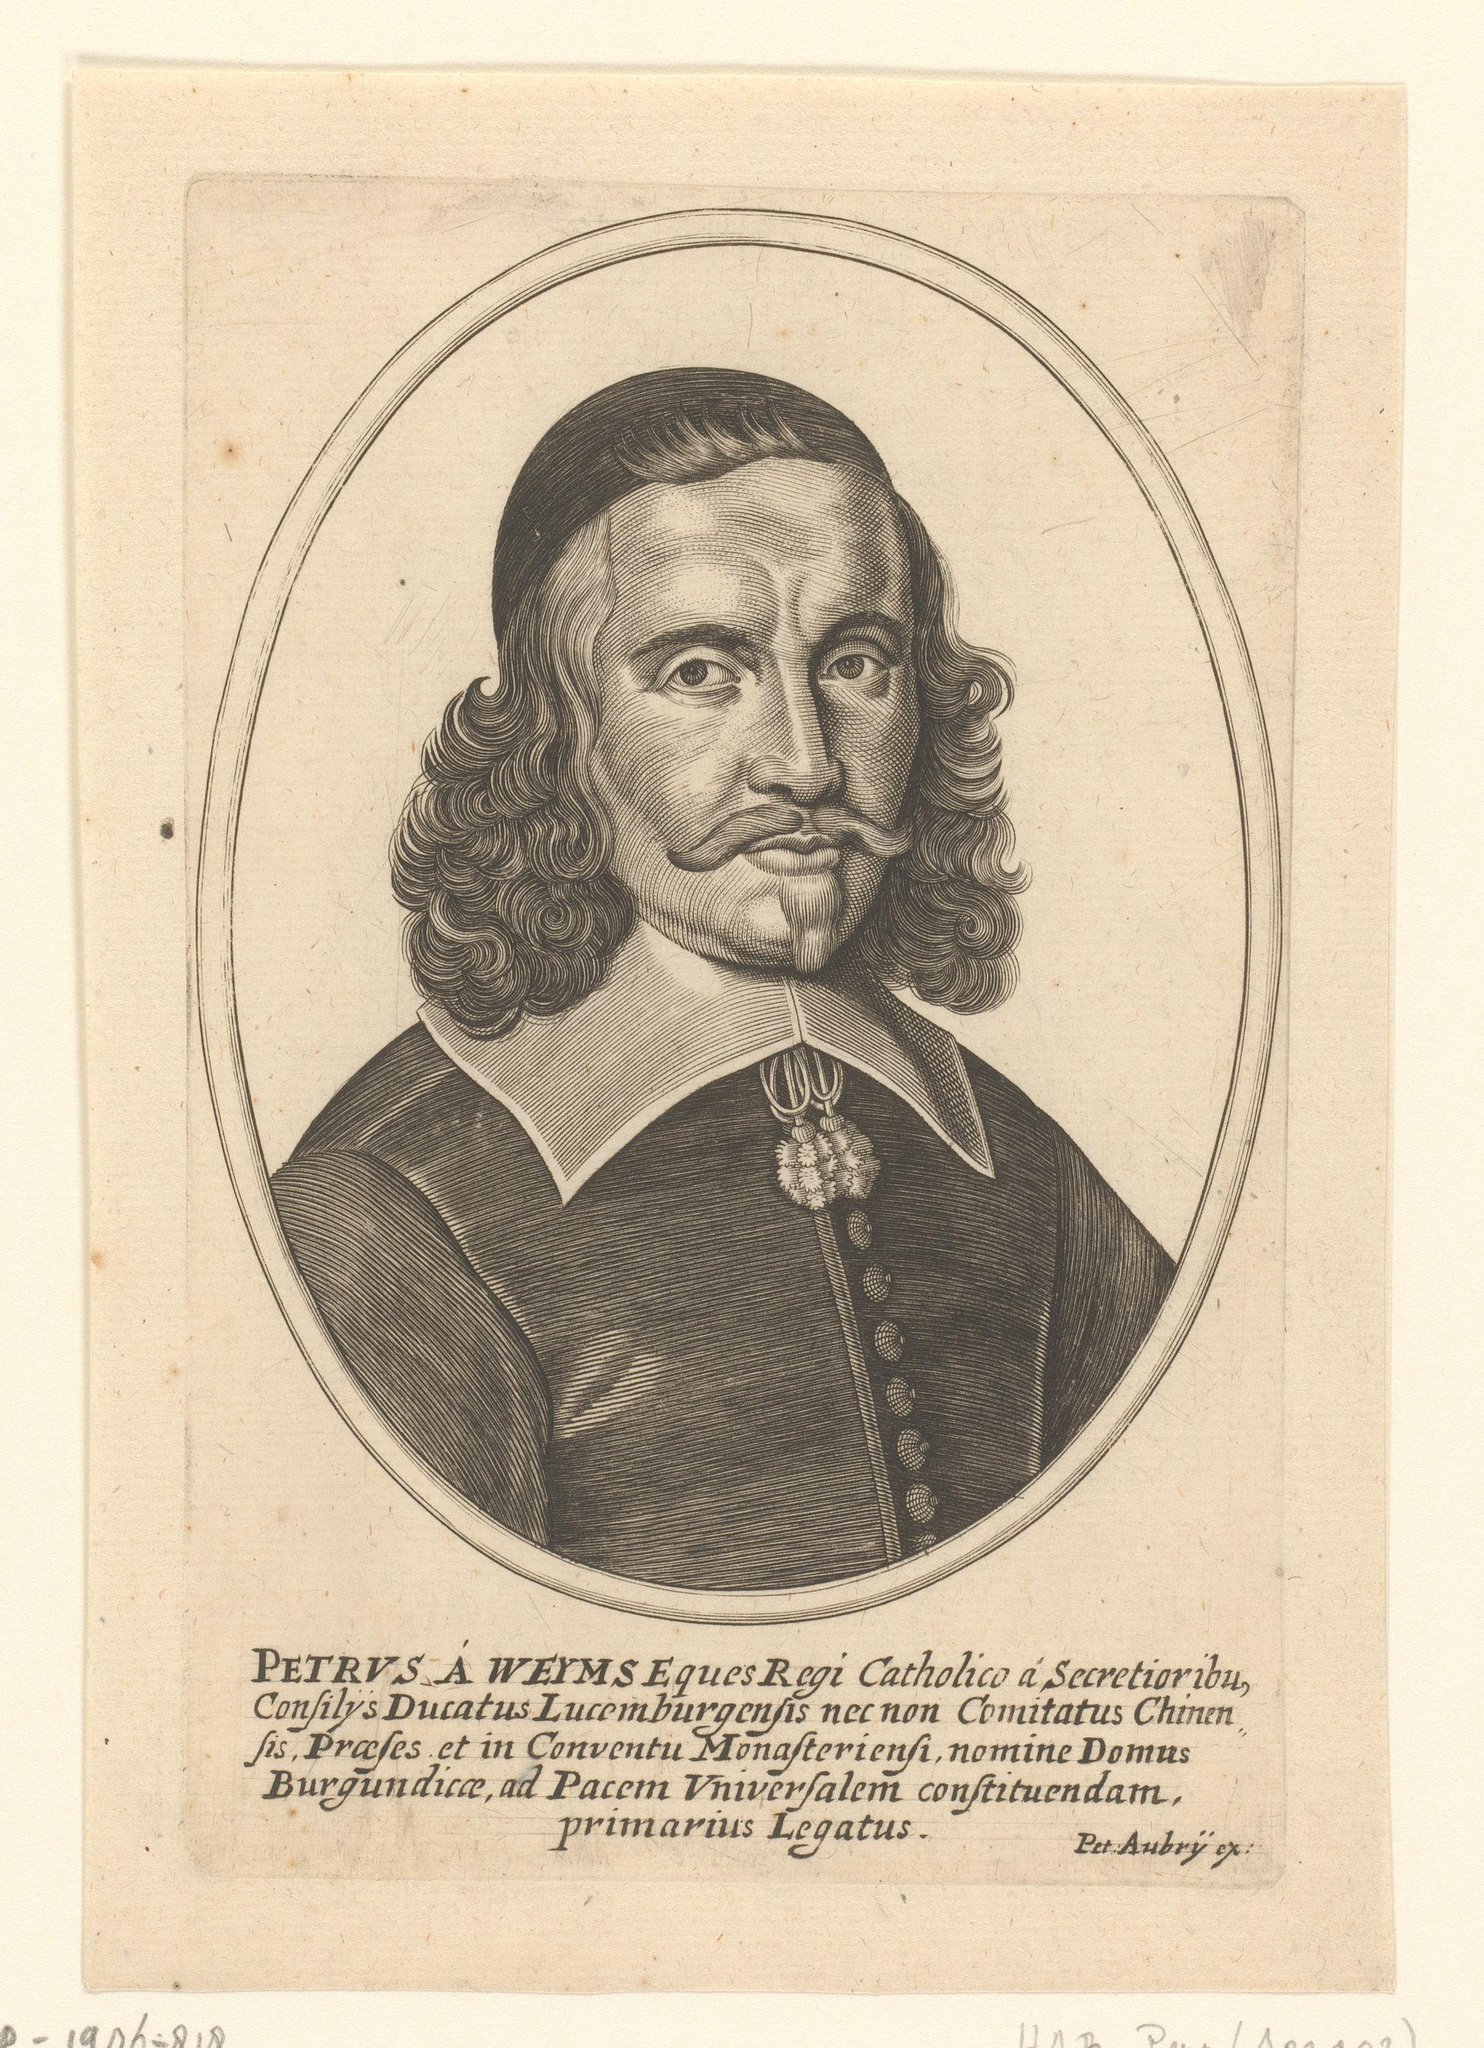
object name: print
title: Portretten van afgevaardigden bij de Vrede van Westfalen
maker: Anonymous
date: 1648-1650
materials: paper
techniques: engraving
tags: historical persons, diplomacy, diplomat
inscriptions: number: ‘739’, collector's mark: Lugt 2228